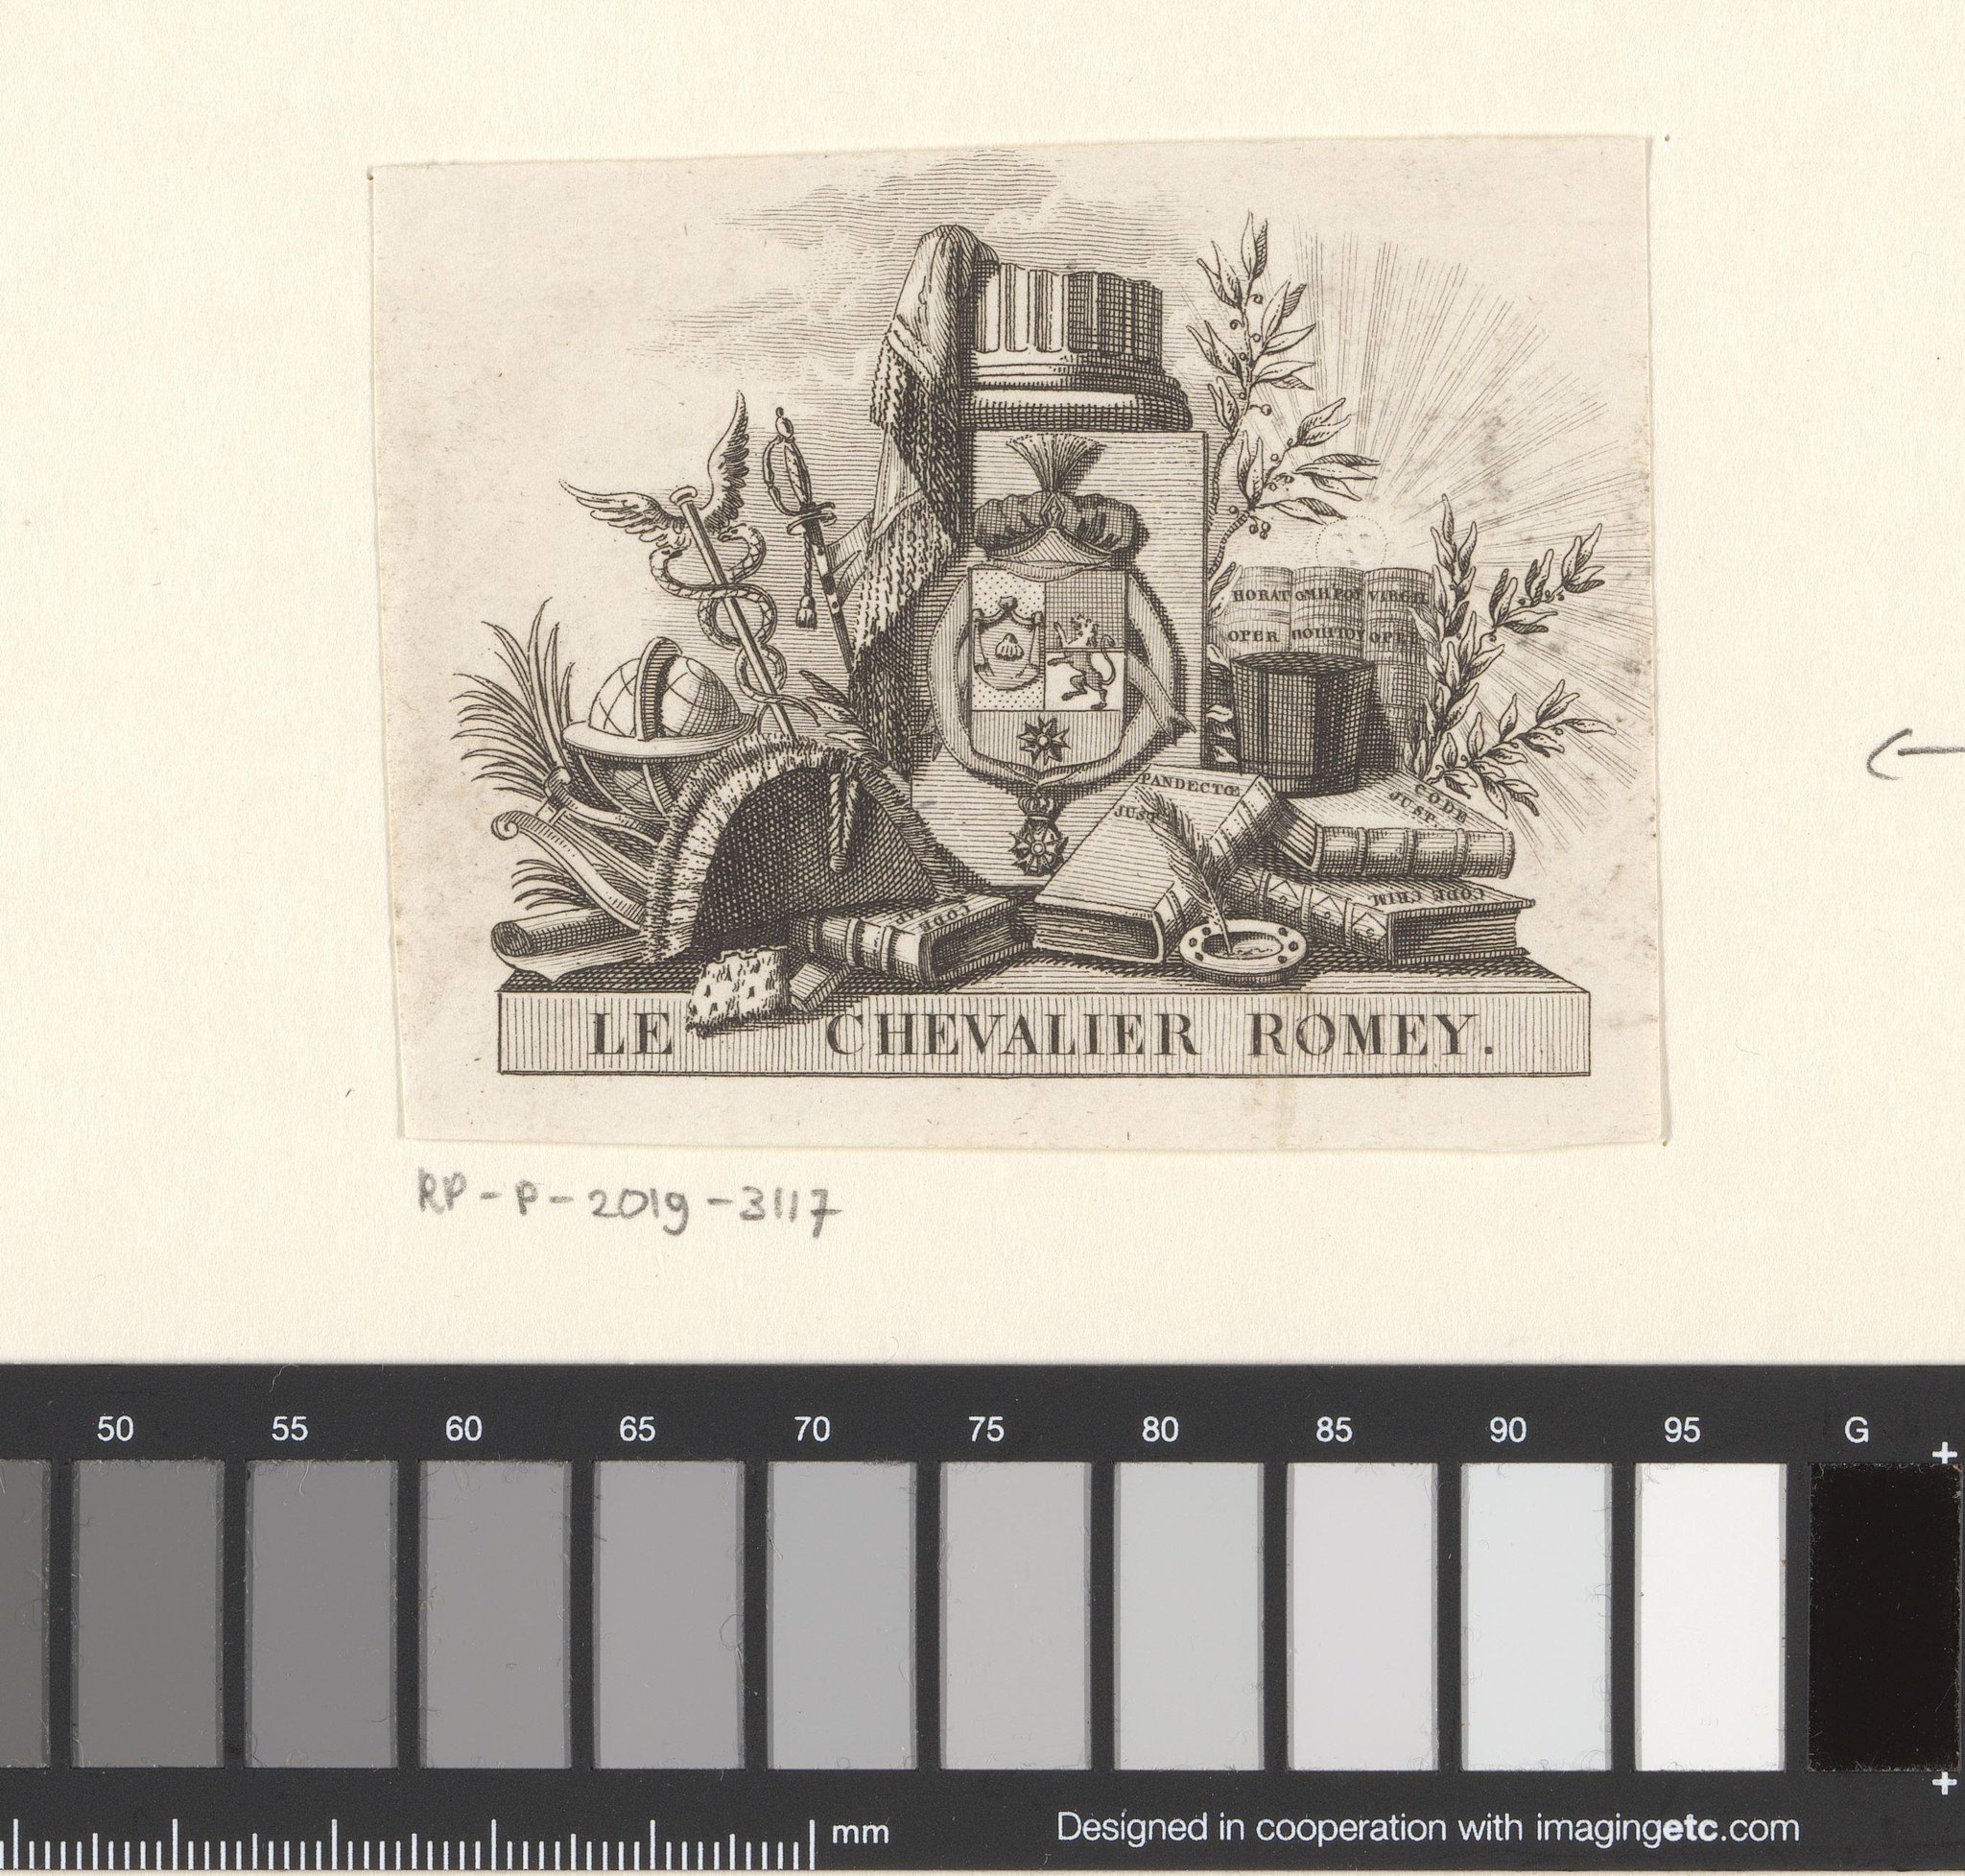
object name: print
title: Vignet met een wapenschild, boeken en een caduceus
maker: Anonymous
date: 1650-1799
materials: paper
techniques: etching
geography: france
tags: book, illustration ~ printed matter, book, caduceus (staff with two snakes, attribute of mercury), armorial bearing, heraldry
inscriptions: collector's mark: Lugt 2228